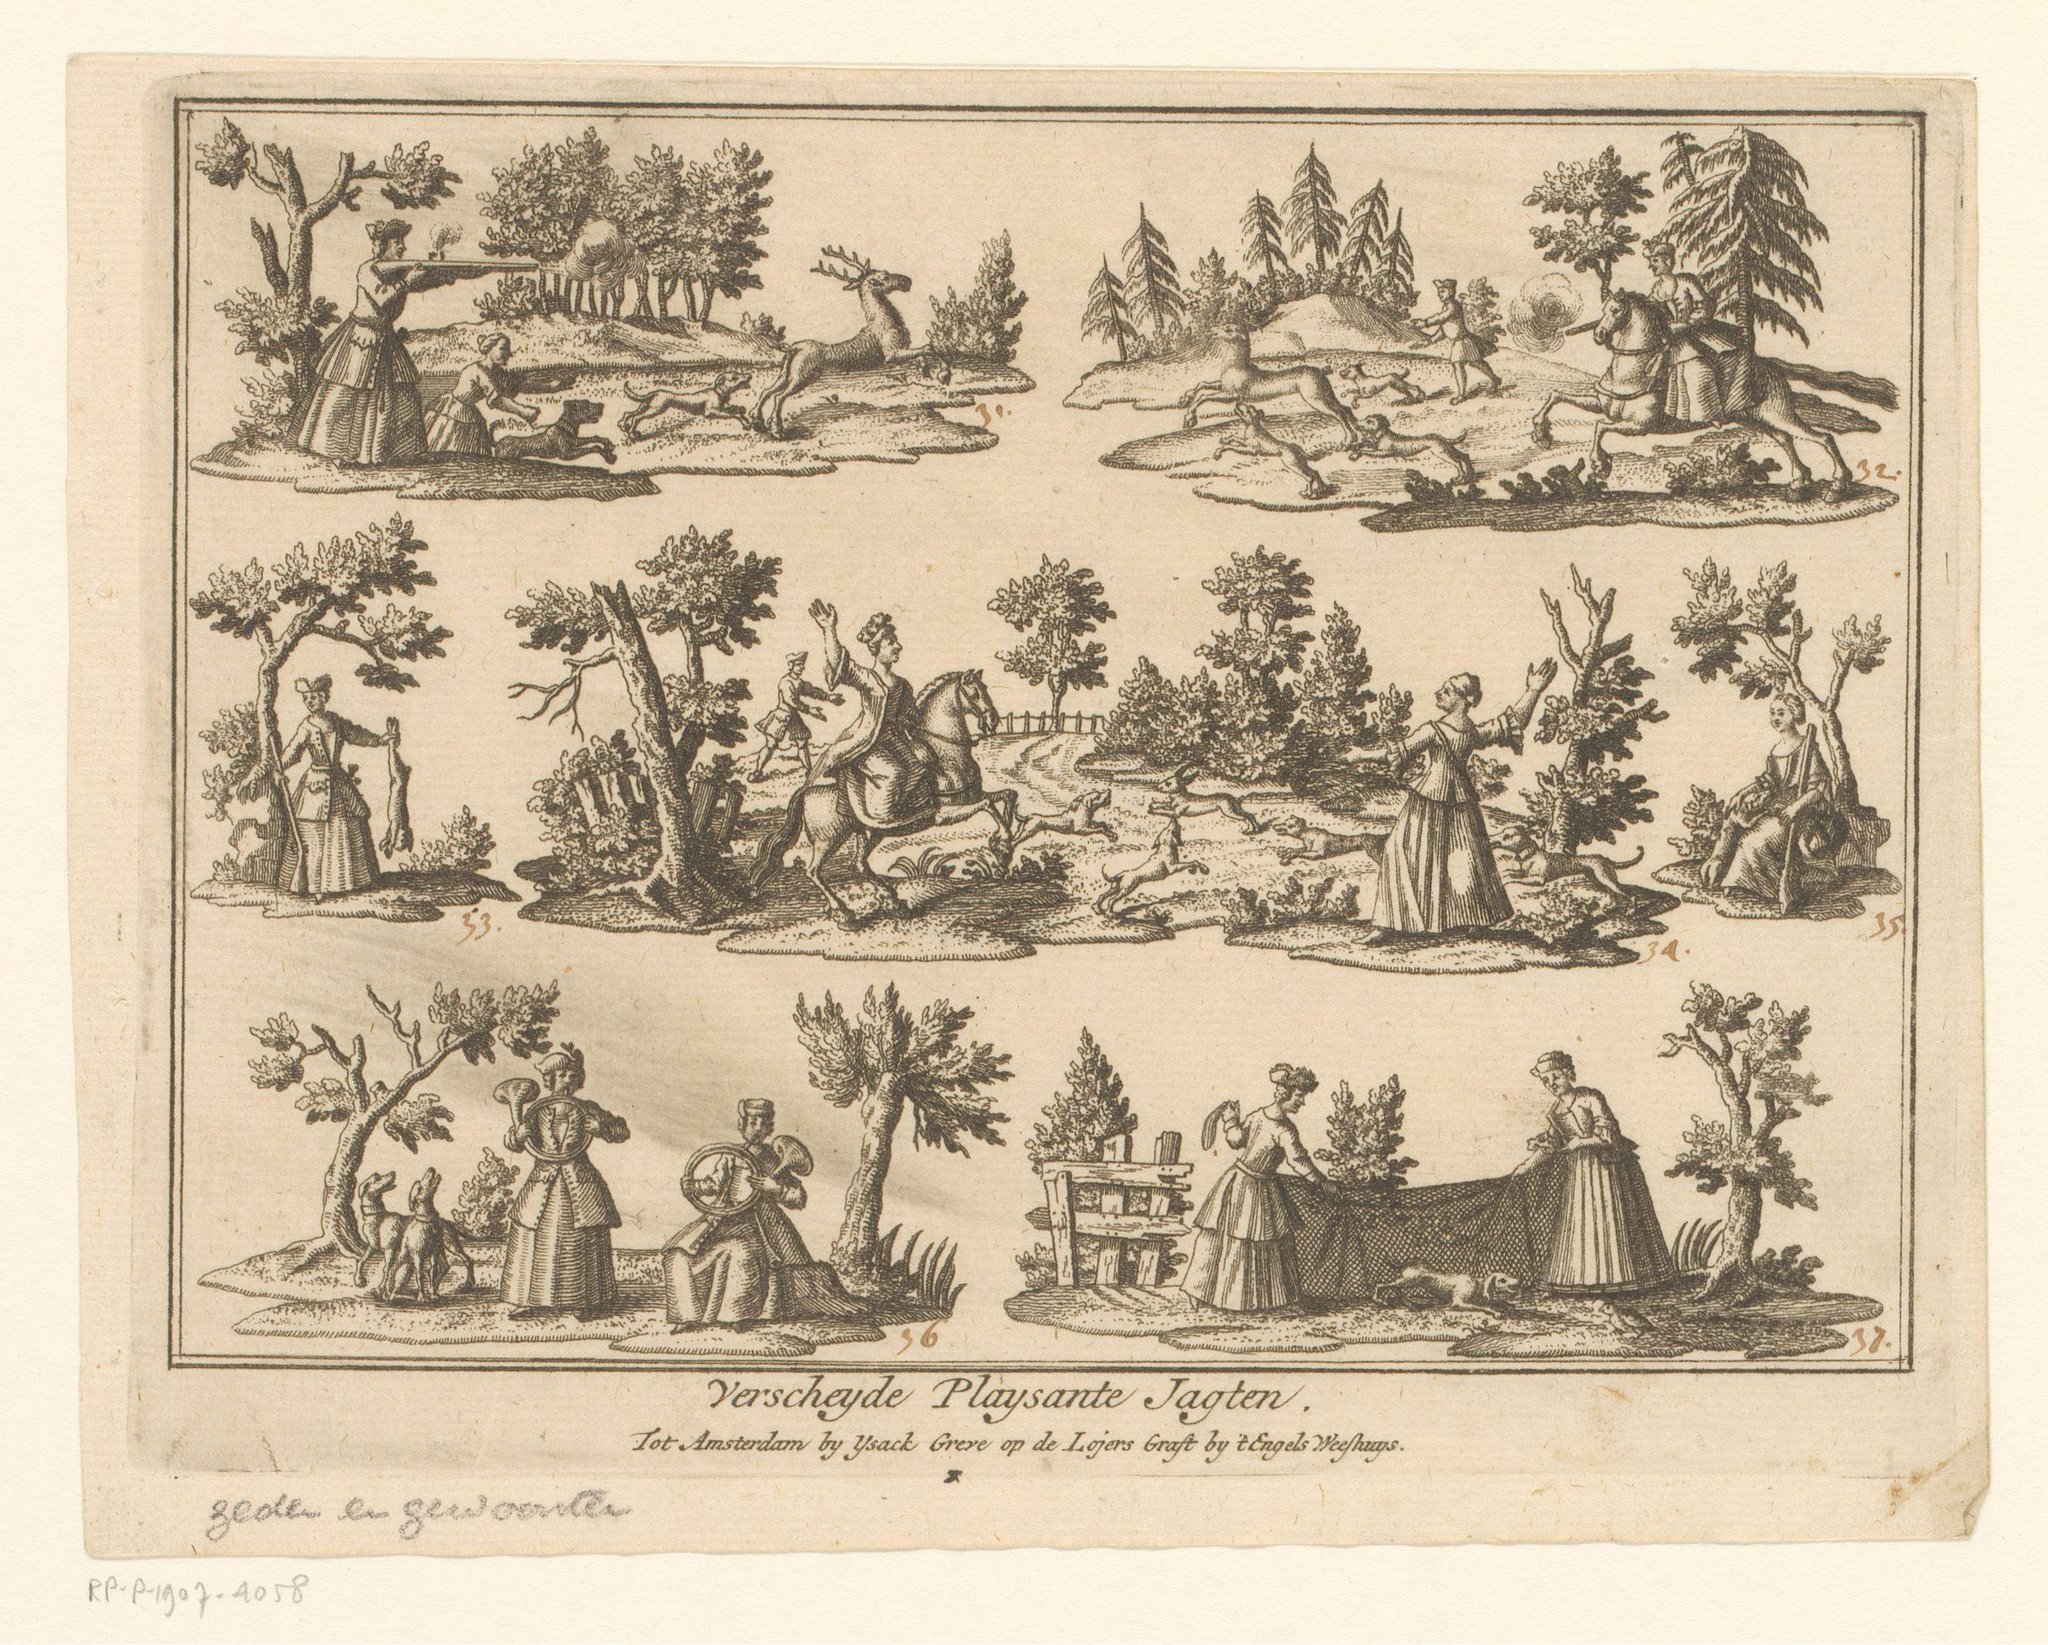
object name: titelprent, frontispice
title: Verscheyde Playsante Jagten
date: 1718-1757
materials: paper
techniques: etching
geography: amsterdam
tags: stag-hunting, hunting dogs, hoofed animals: deer (+animal(s) being hit, shot, caught), game, hunted animals, hare-hunting, rabbit-hunting, hunting horn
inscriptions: collector's mark: Lugt 2228, number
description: Op de prent staan zeven landschappen met jachtvoorstellingen. Centraal een voorstelling van een hazenjacht, met een vrouw op een paard en drie honden die naar een haas rennen. De voorstellingen zijn met pen genummerd.